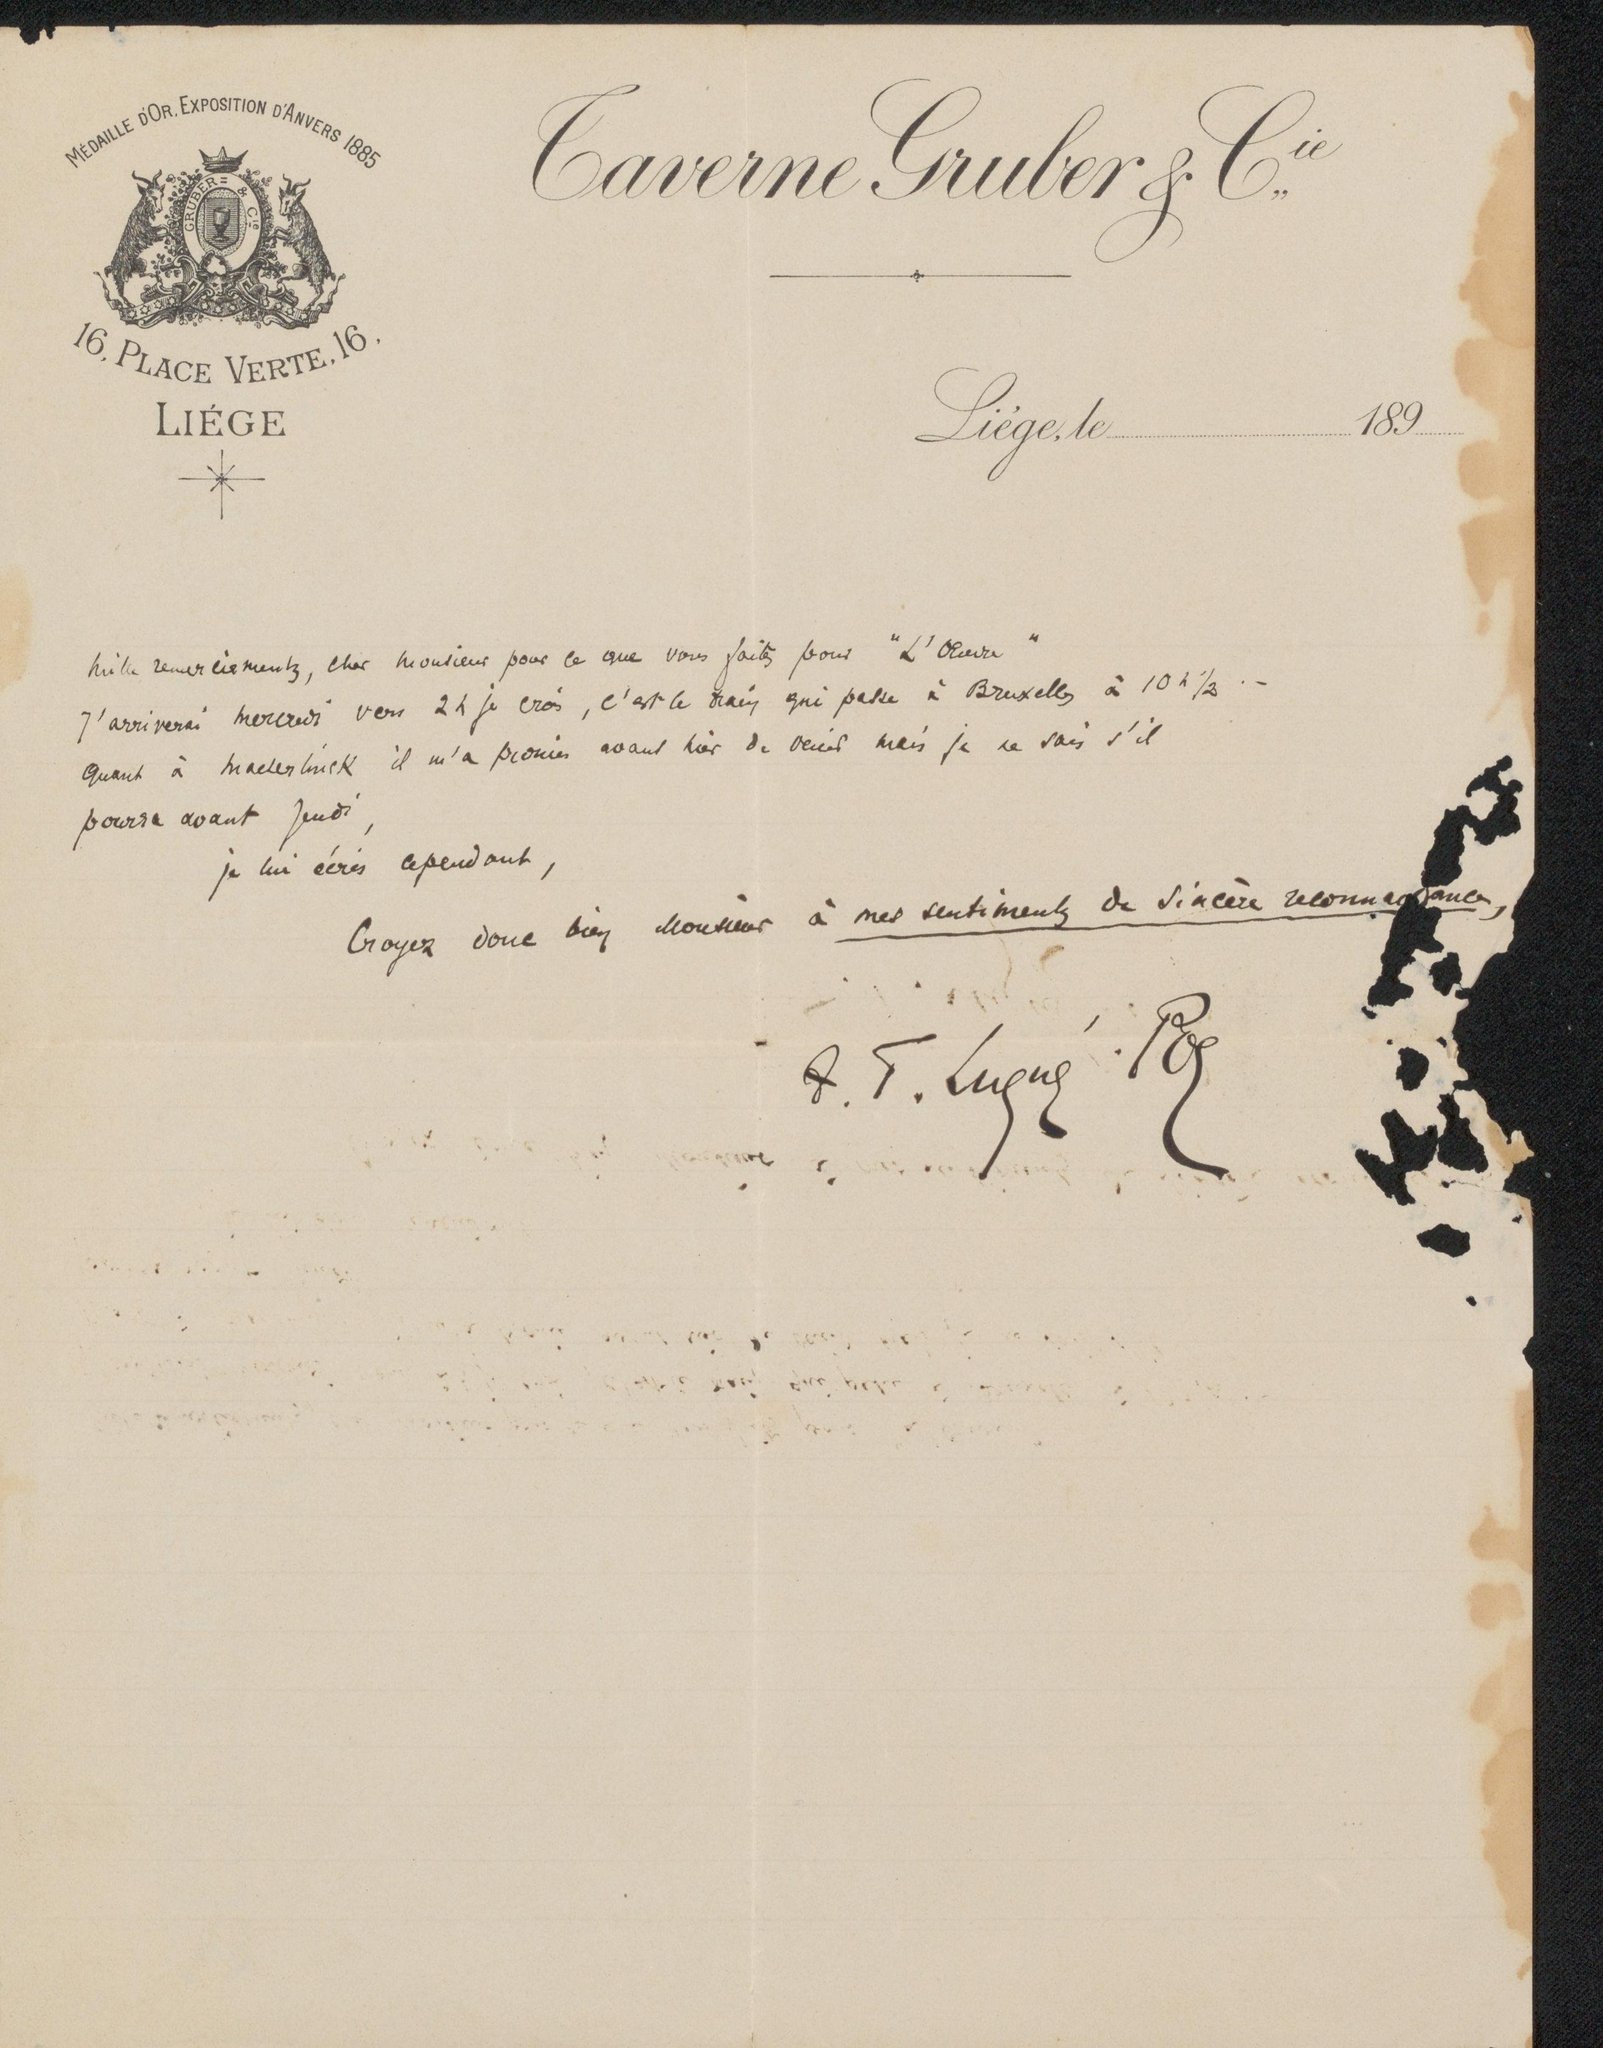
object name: letter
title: Brief aan Philip Zilcken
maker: lugné-poe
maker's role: acteur, theaterdirecteur, theatervormgever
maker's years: 1869-1940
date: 1893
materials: ink, paper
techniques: pen, printing, writing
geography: liège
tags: painter, draughtsman, philip zilcken, brussels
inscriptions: collector's mark: ‘RPK’, watermark